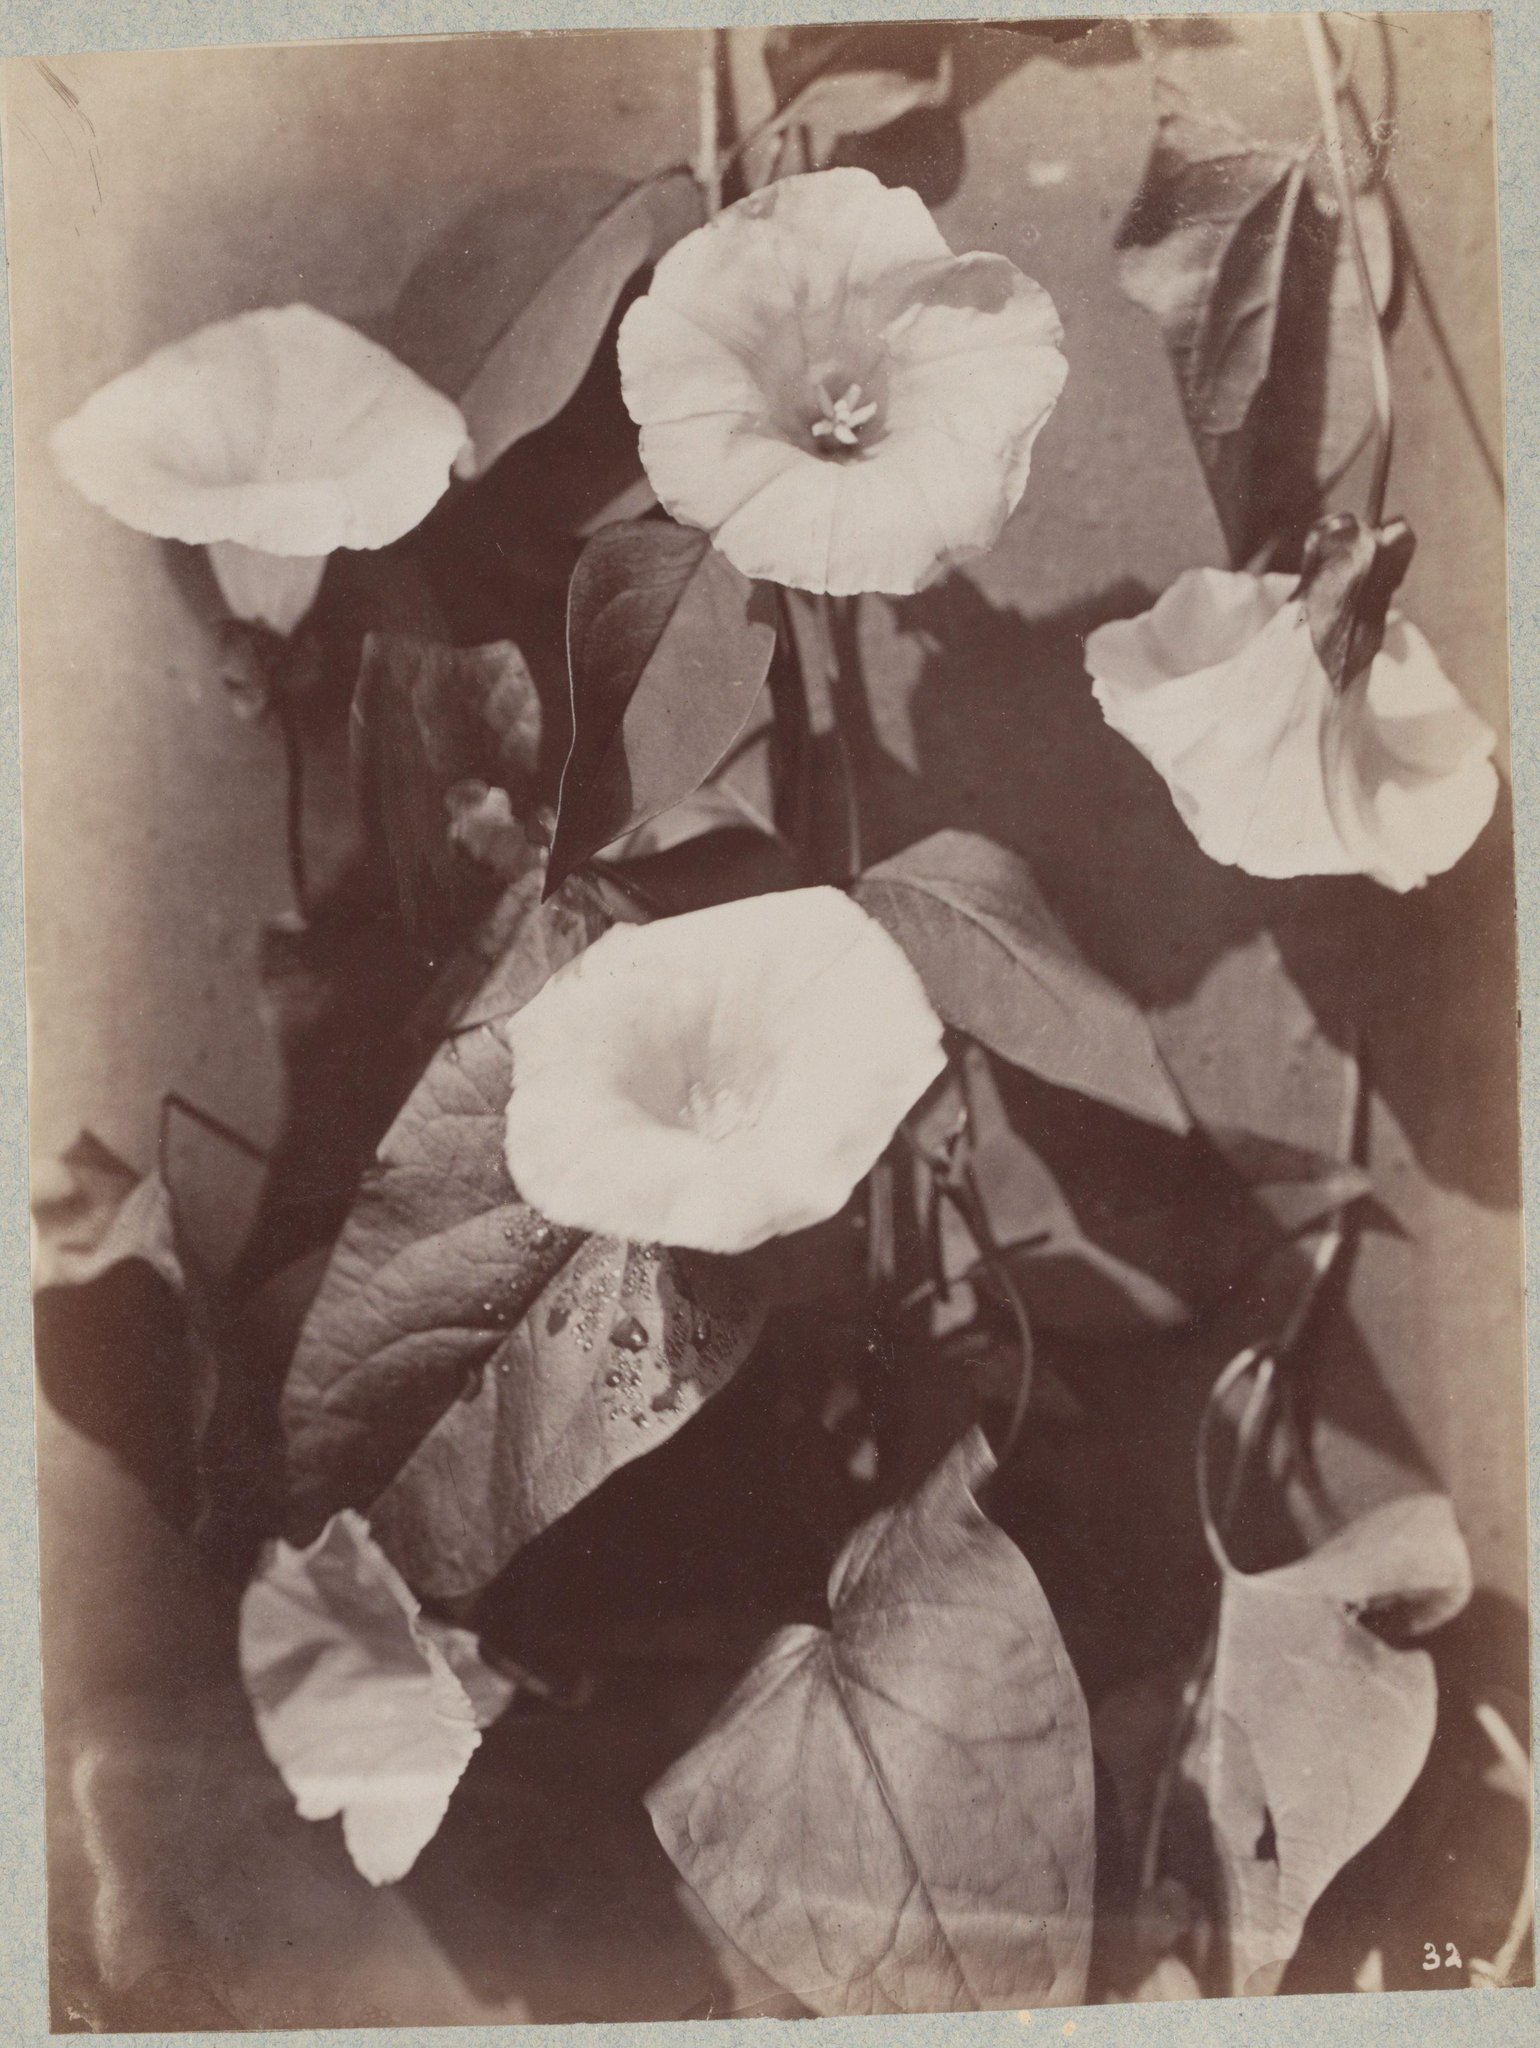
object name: photograph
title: Bloemstudie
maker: a. calavas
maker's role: publisher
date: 1875-1895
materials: cardboard, photographic support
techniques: albumen print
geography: paris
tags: flowers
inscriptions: number: ‘32’, collector's mark: Lugt 3937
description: Onderdeel van Verzamelband met foto's van bloemstudies.